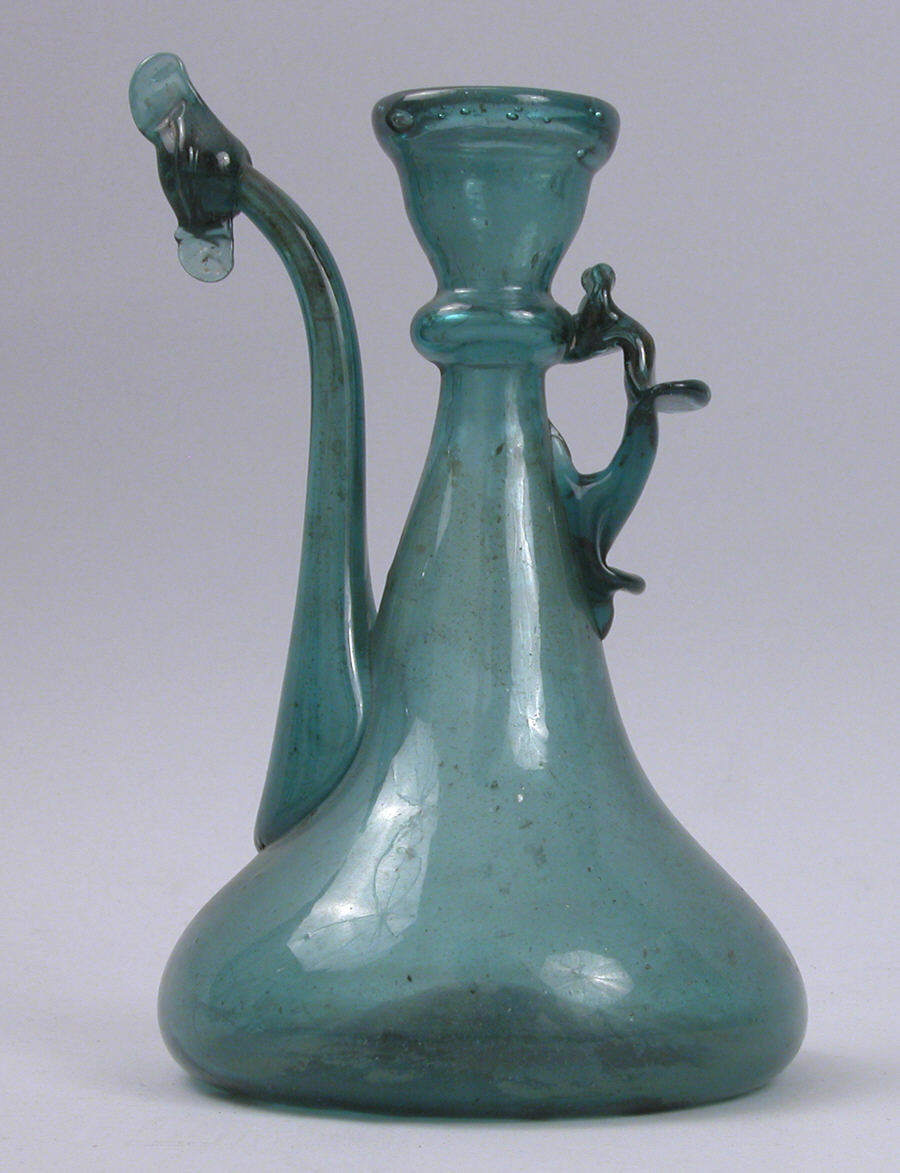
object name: ewer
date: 1701-1900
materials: glass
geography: iran